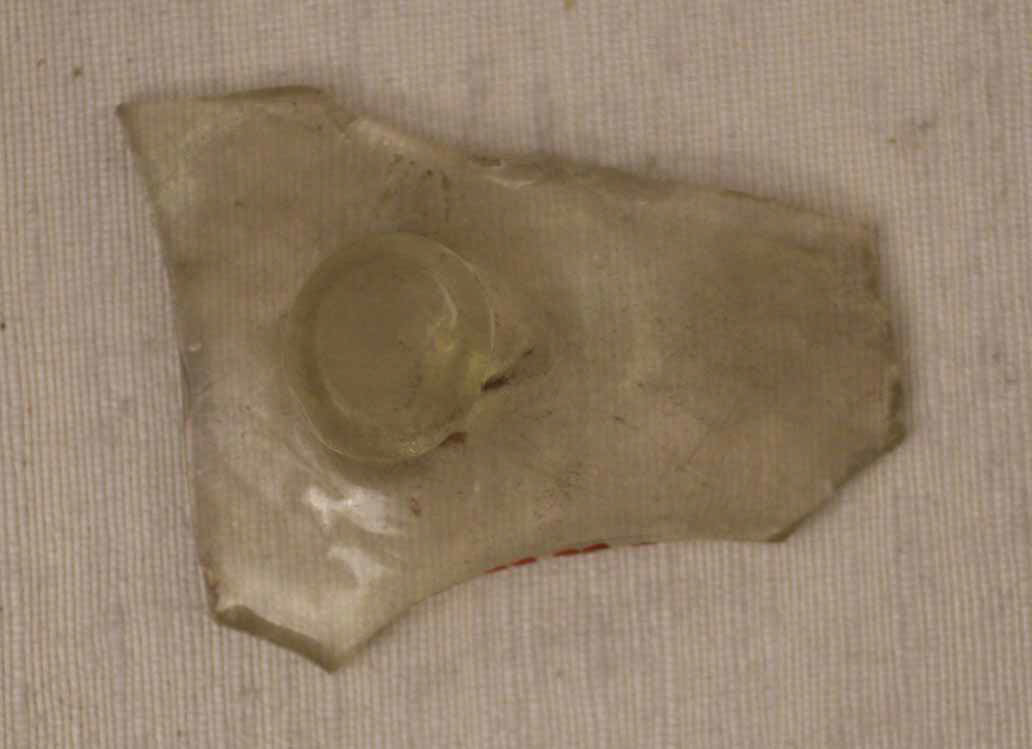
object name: fragment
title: Glass Fragment with Knob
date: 801-900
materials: glass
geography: iraq